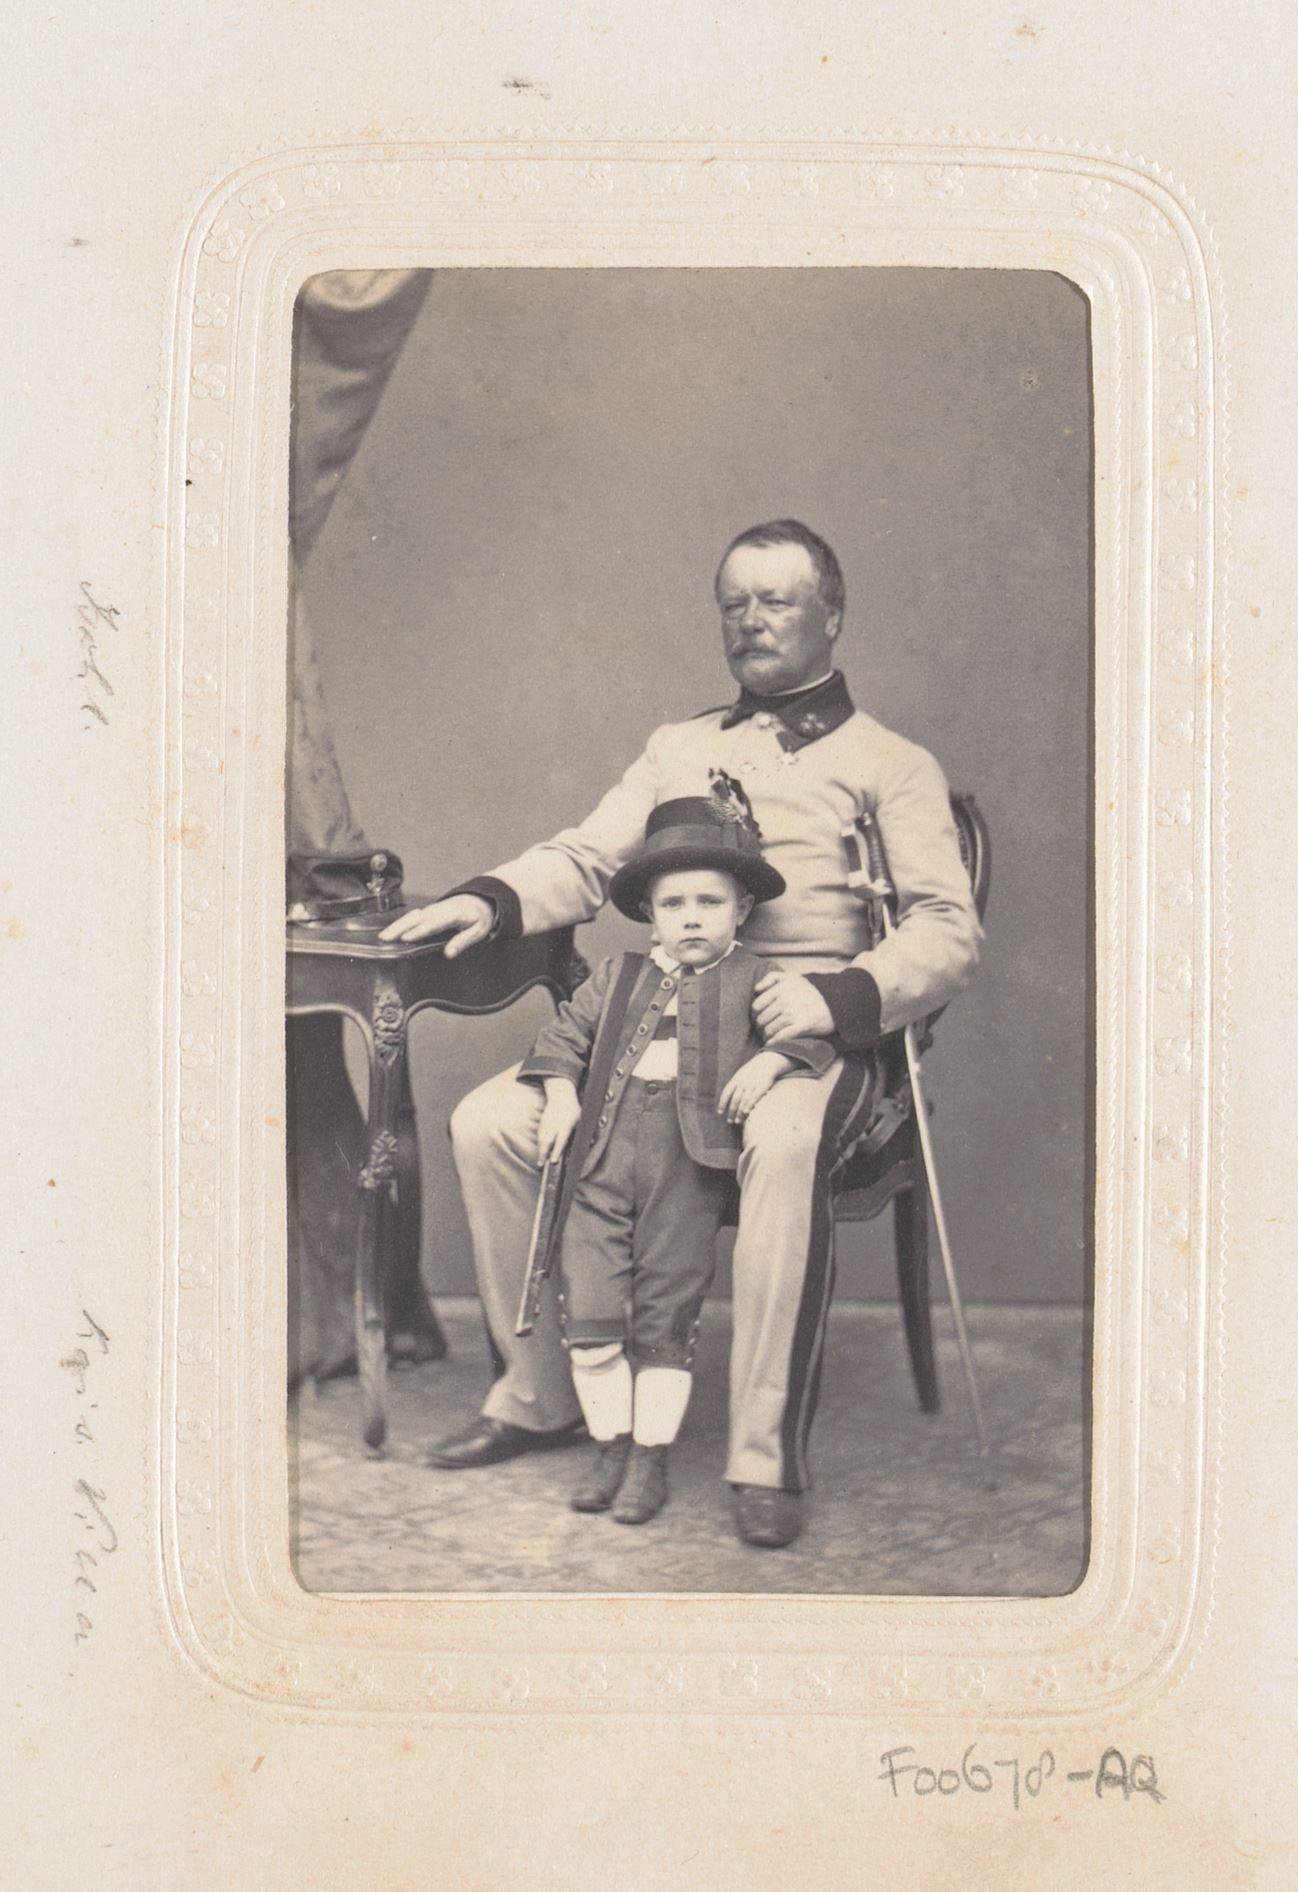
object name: photograph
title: Portret van een zittende man in uniform met jongen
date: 1860-1880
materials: cardboard, photographic support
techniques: albumen print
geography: salzburg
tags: historical persons, (military) uniforms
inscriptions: inscription: ‘Baldi & Würthle/ photographische anstalt/ Salzburg/ Riedenburf, Baldi-Hof, No.17’